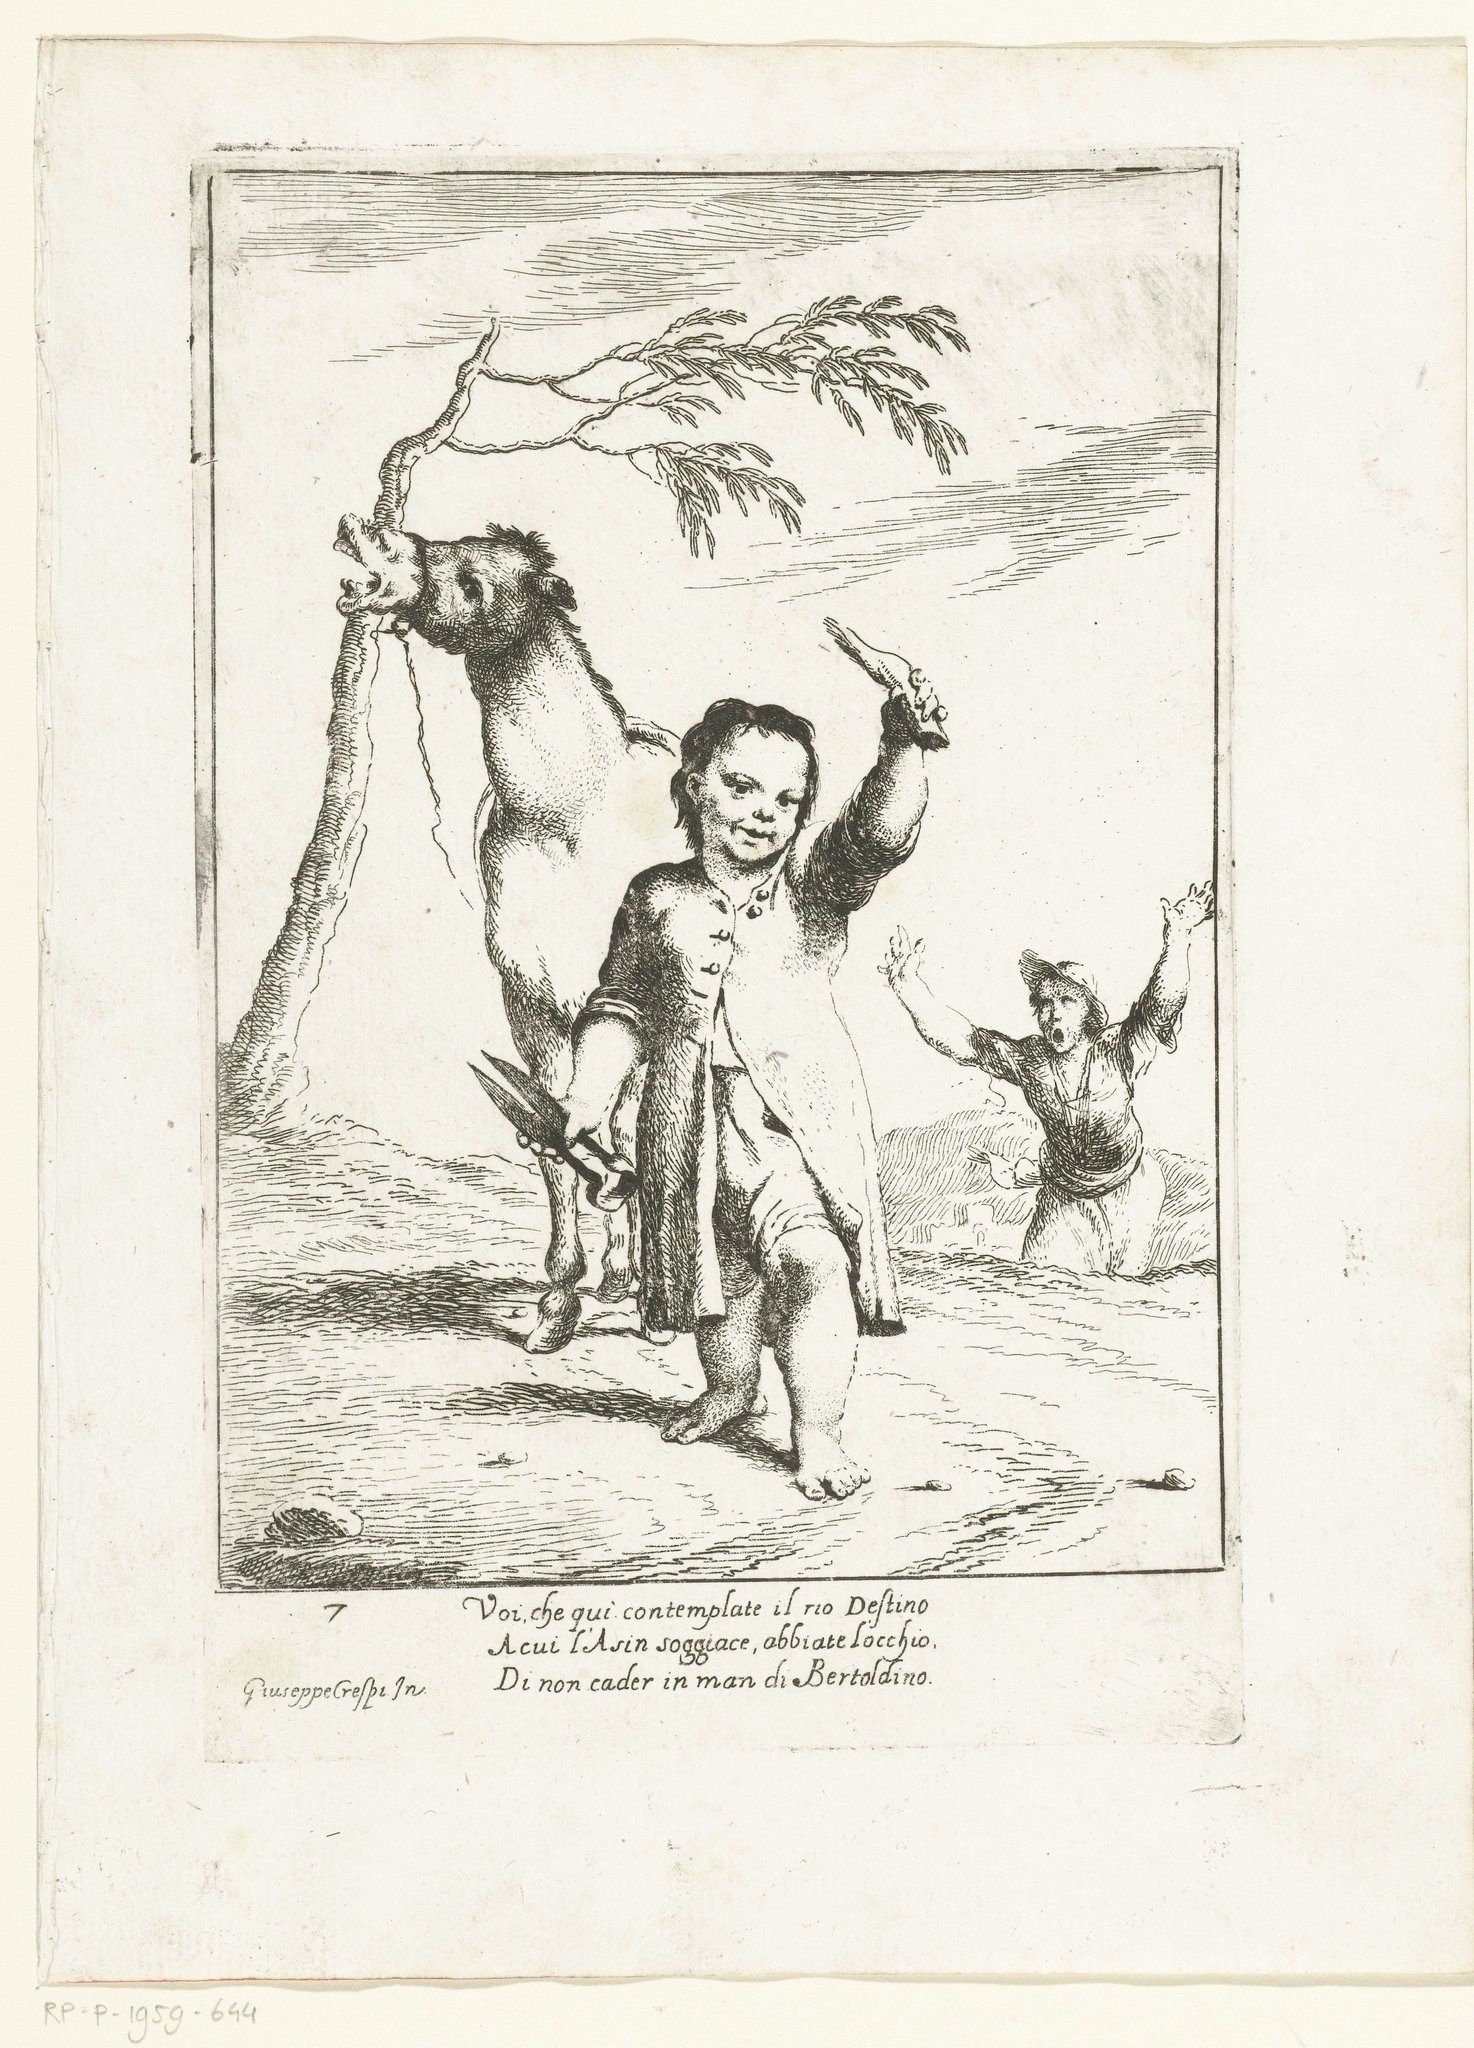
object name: print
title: Historie van Bertoldo, Bertoldino en Cacasenno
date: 1710-1715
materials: paper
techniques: etching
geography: italy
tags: ass, donkey, literary characters and objects, man tormenting animal(s)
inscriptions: collector's mark: Lugt 2228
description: Bertoldino heeft de oren van de ezel afgesneden. In zijn rechterhand de schaar, in zijn linker een oor. Achter hem staat de ezel te balken en komt Malcolfa ontzet aanrennen. Onder de voorstelling een drieregelig rijmpje in het Italiaans. Prent uit een reeks van acht met de streken van Bertoldino, onderdeel van een serie van twintig prenten.